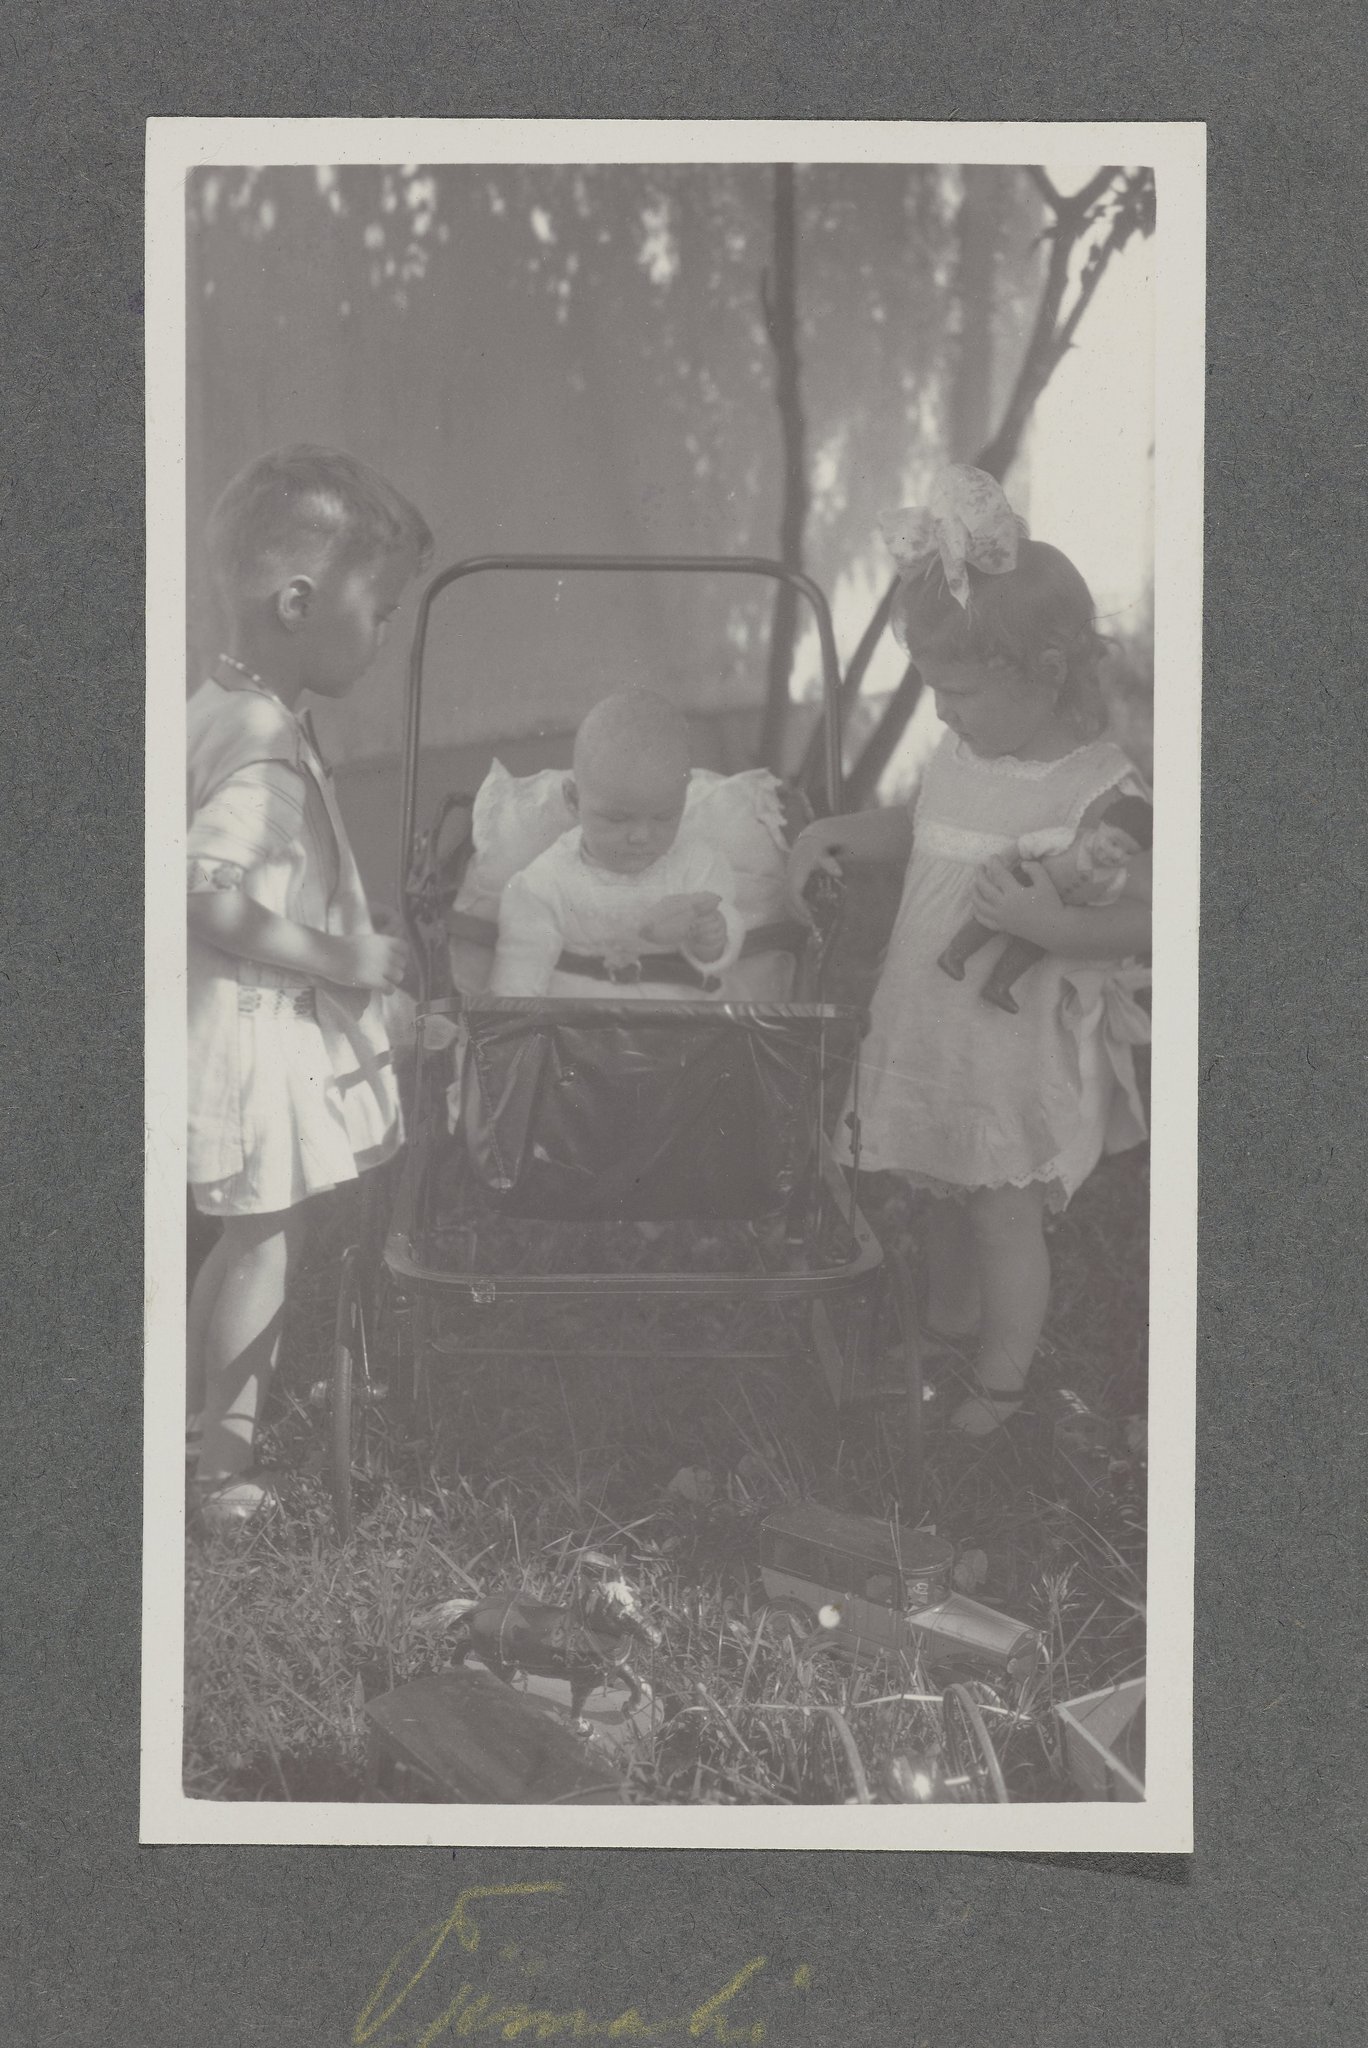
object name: photograph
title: Klaas en Tiny Kleiterp en baby Pieteke in een kinderwagen in Tjimahi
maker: klaas kleiterp (i)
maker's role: arts, officier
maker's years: 1892-1943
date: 1912-1923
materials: paper, photographic support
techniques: gelatin silver print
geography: tjimahi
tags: baby-carriage, pram, perambulator, infant, baby ~ the ages of man, brothers or sisters (second degree family relationships), dutch east indies, the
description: Onderdeel van Fotoalbum van de familie Kleiterp-Vermeulen met opnames van de kinderen Klaas en Tiny in Nederlands-Indië.